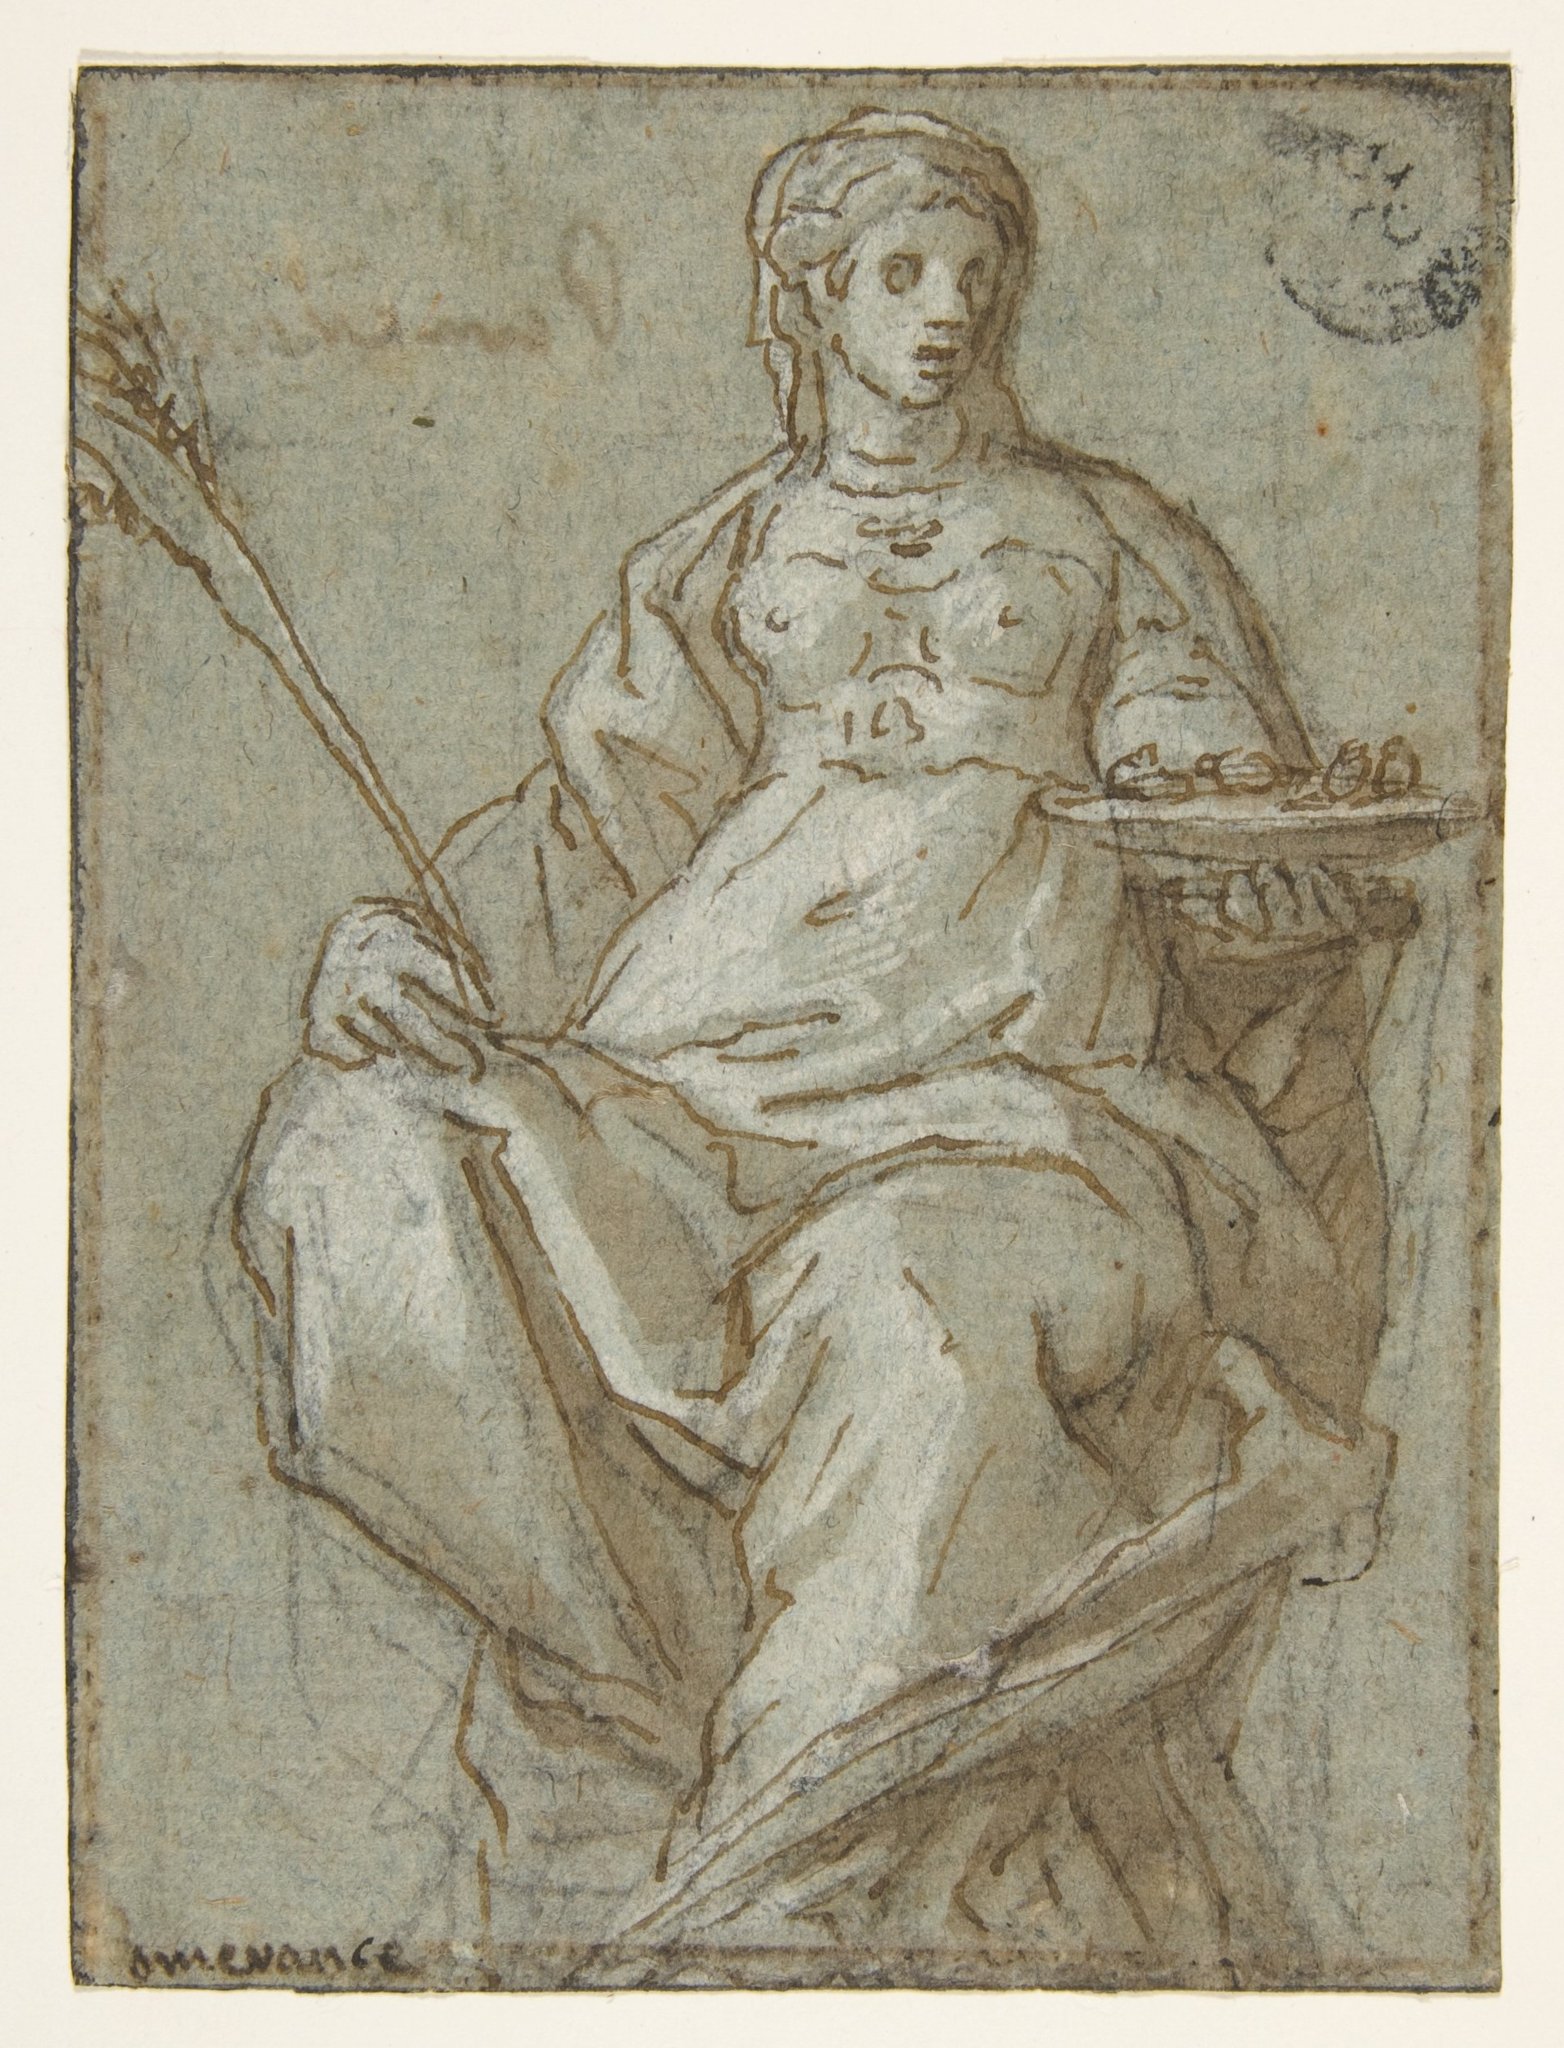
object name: drawing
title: Allegorical Female Figure Holding a Branch and a Dish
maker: lazzaro tavarone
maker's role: artist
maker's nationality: italian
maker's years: 1556-1641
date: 1556-1641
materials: chalk, ink, paper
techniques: brush, highlighting, pen, drawing, wash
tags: women,dishes